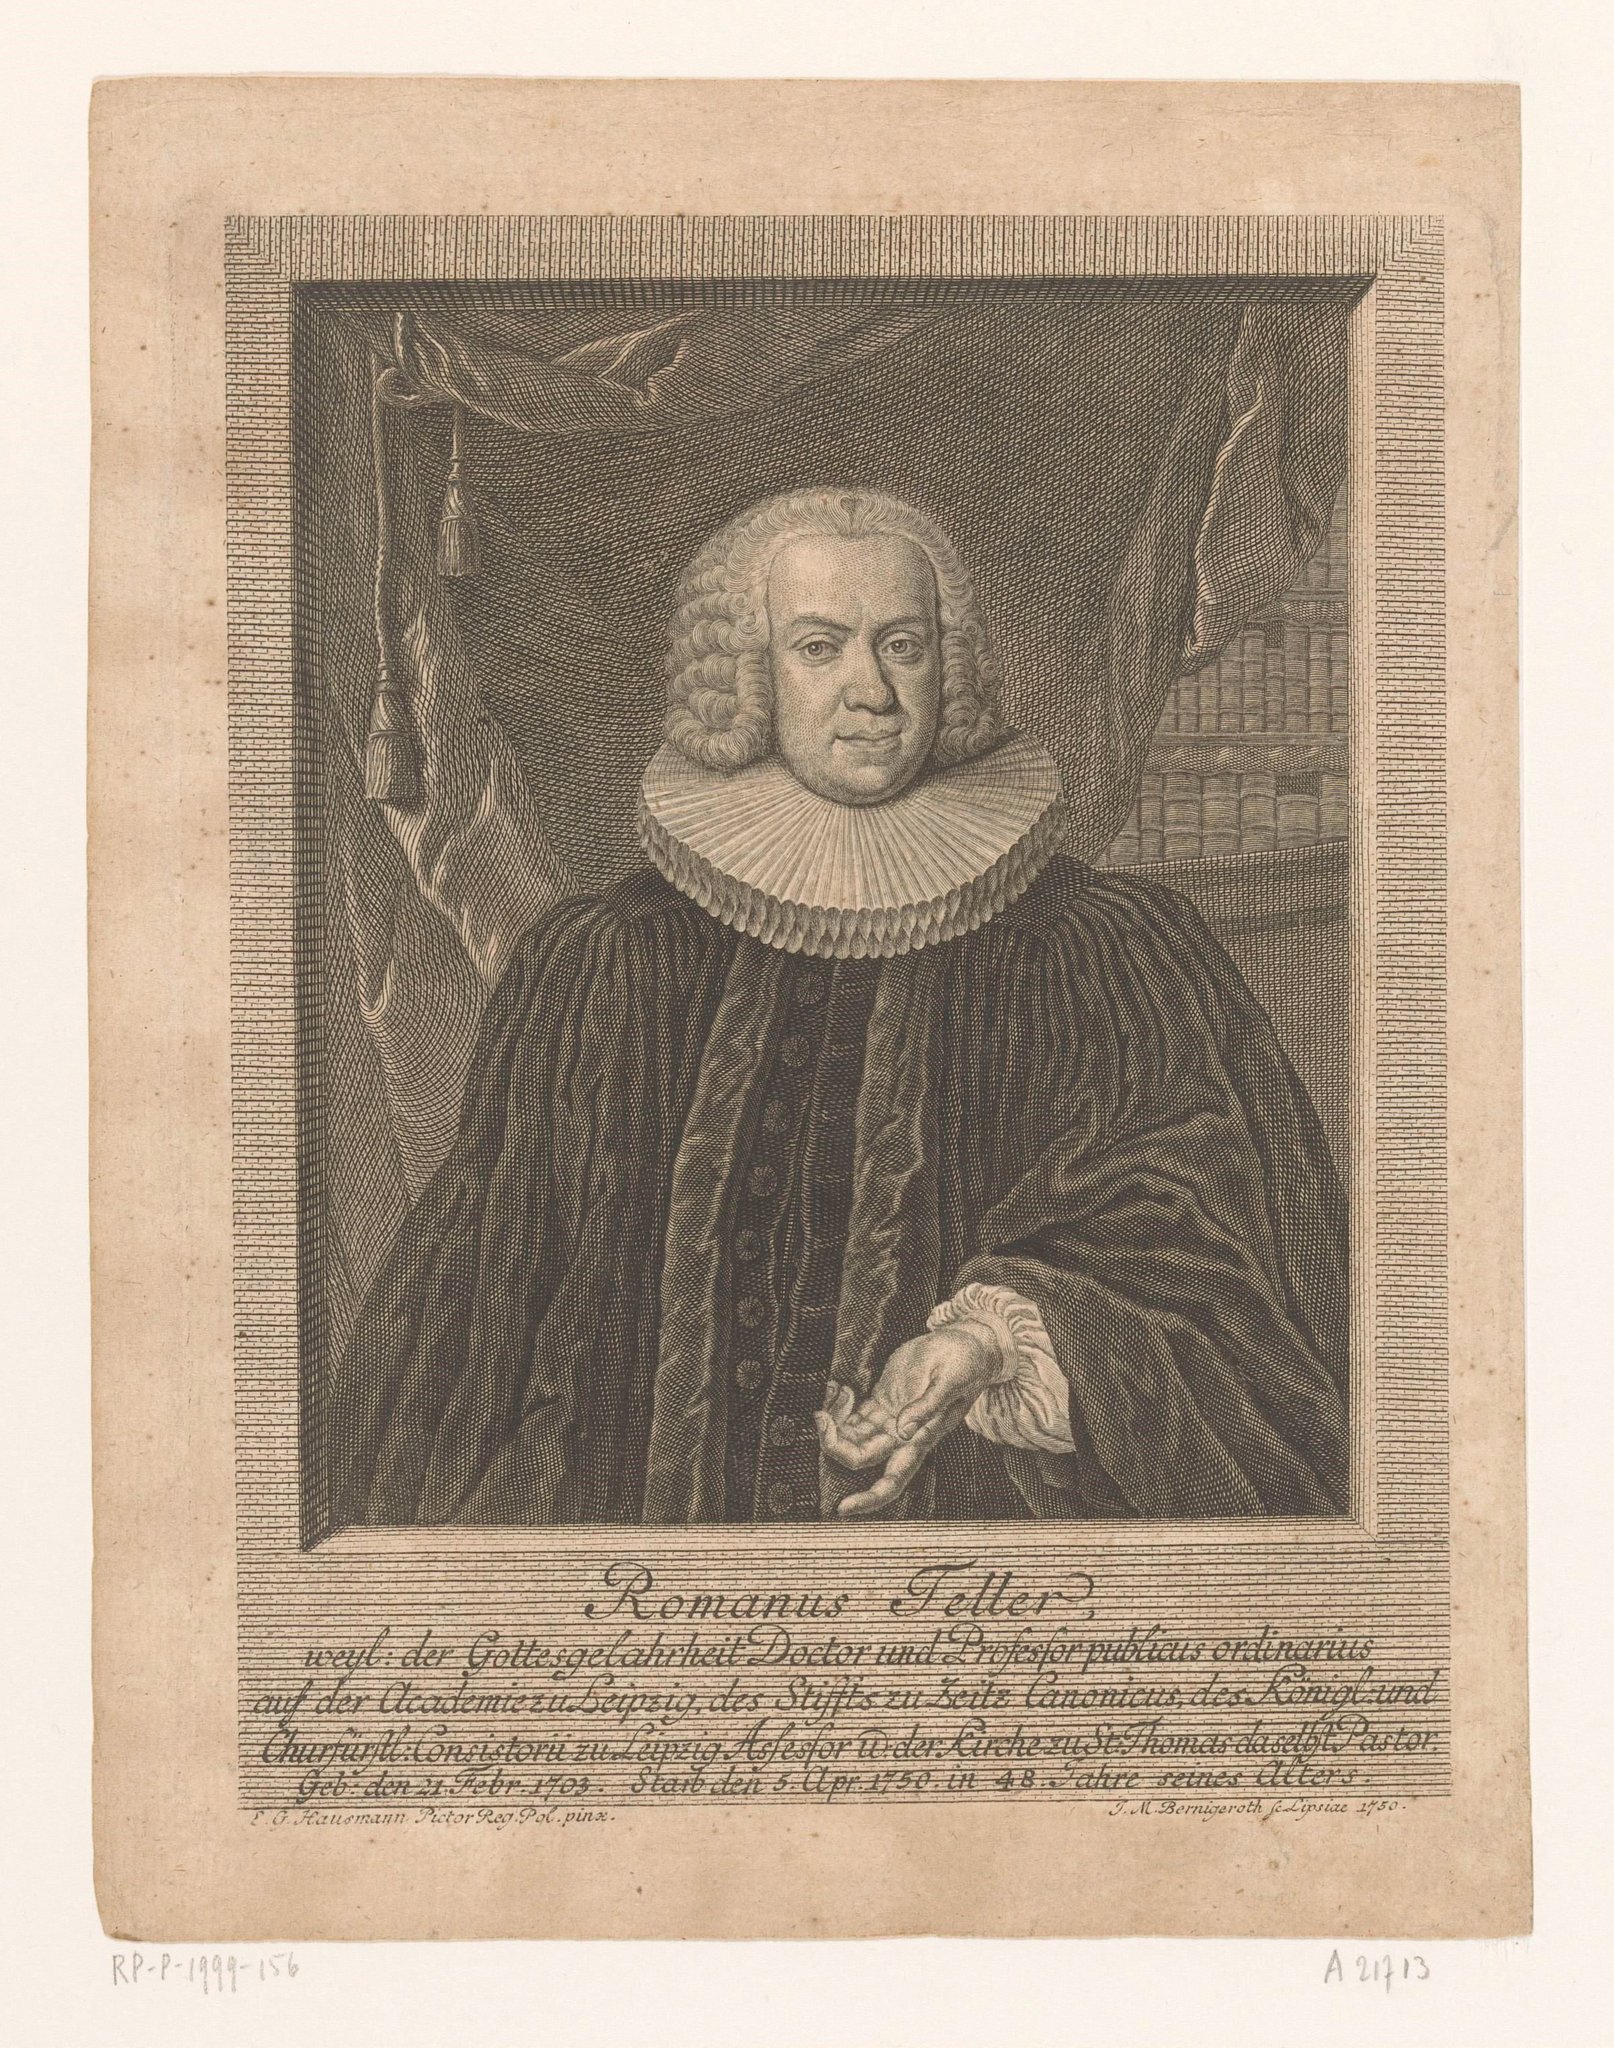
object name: print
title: Portret van Romanus III Teller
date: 1750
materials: paper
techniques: engraving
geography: leipzig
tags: bookshelves, historical persons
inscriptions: collector's mark: Lugt 2228, collector's mark: Lugt 2760